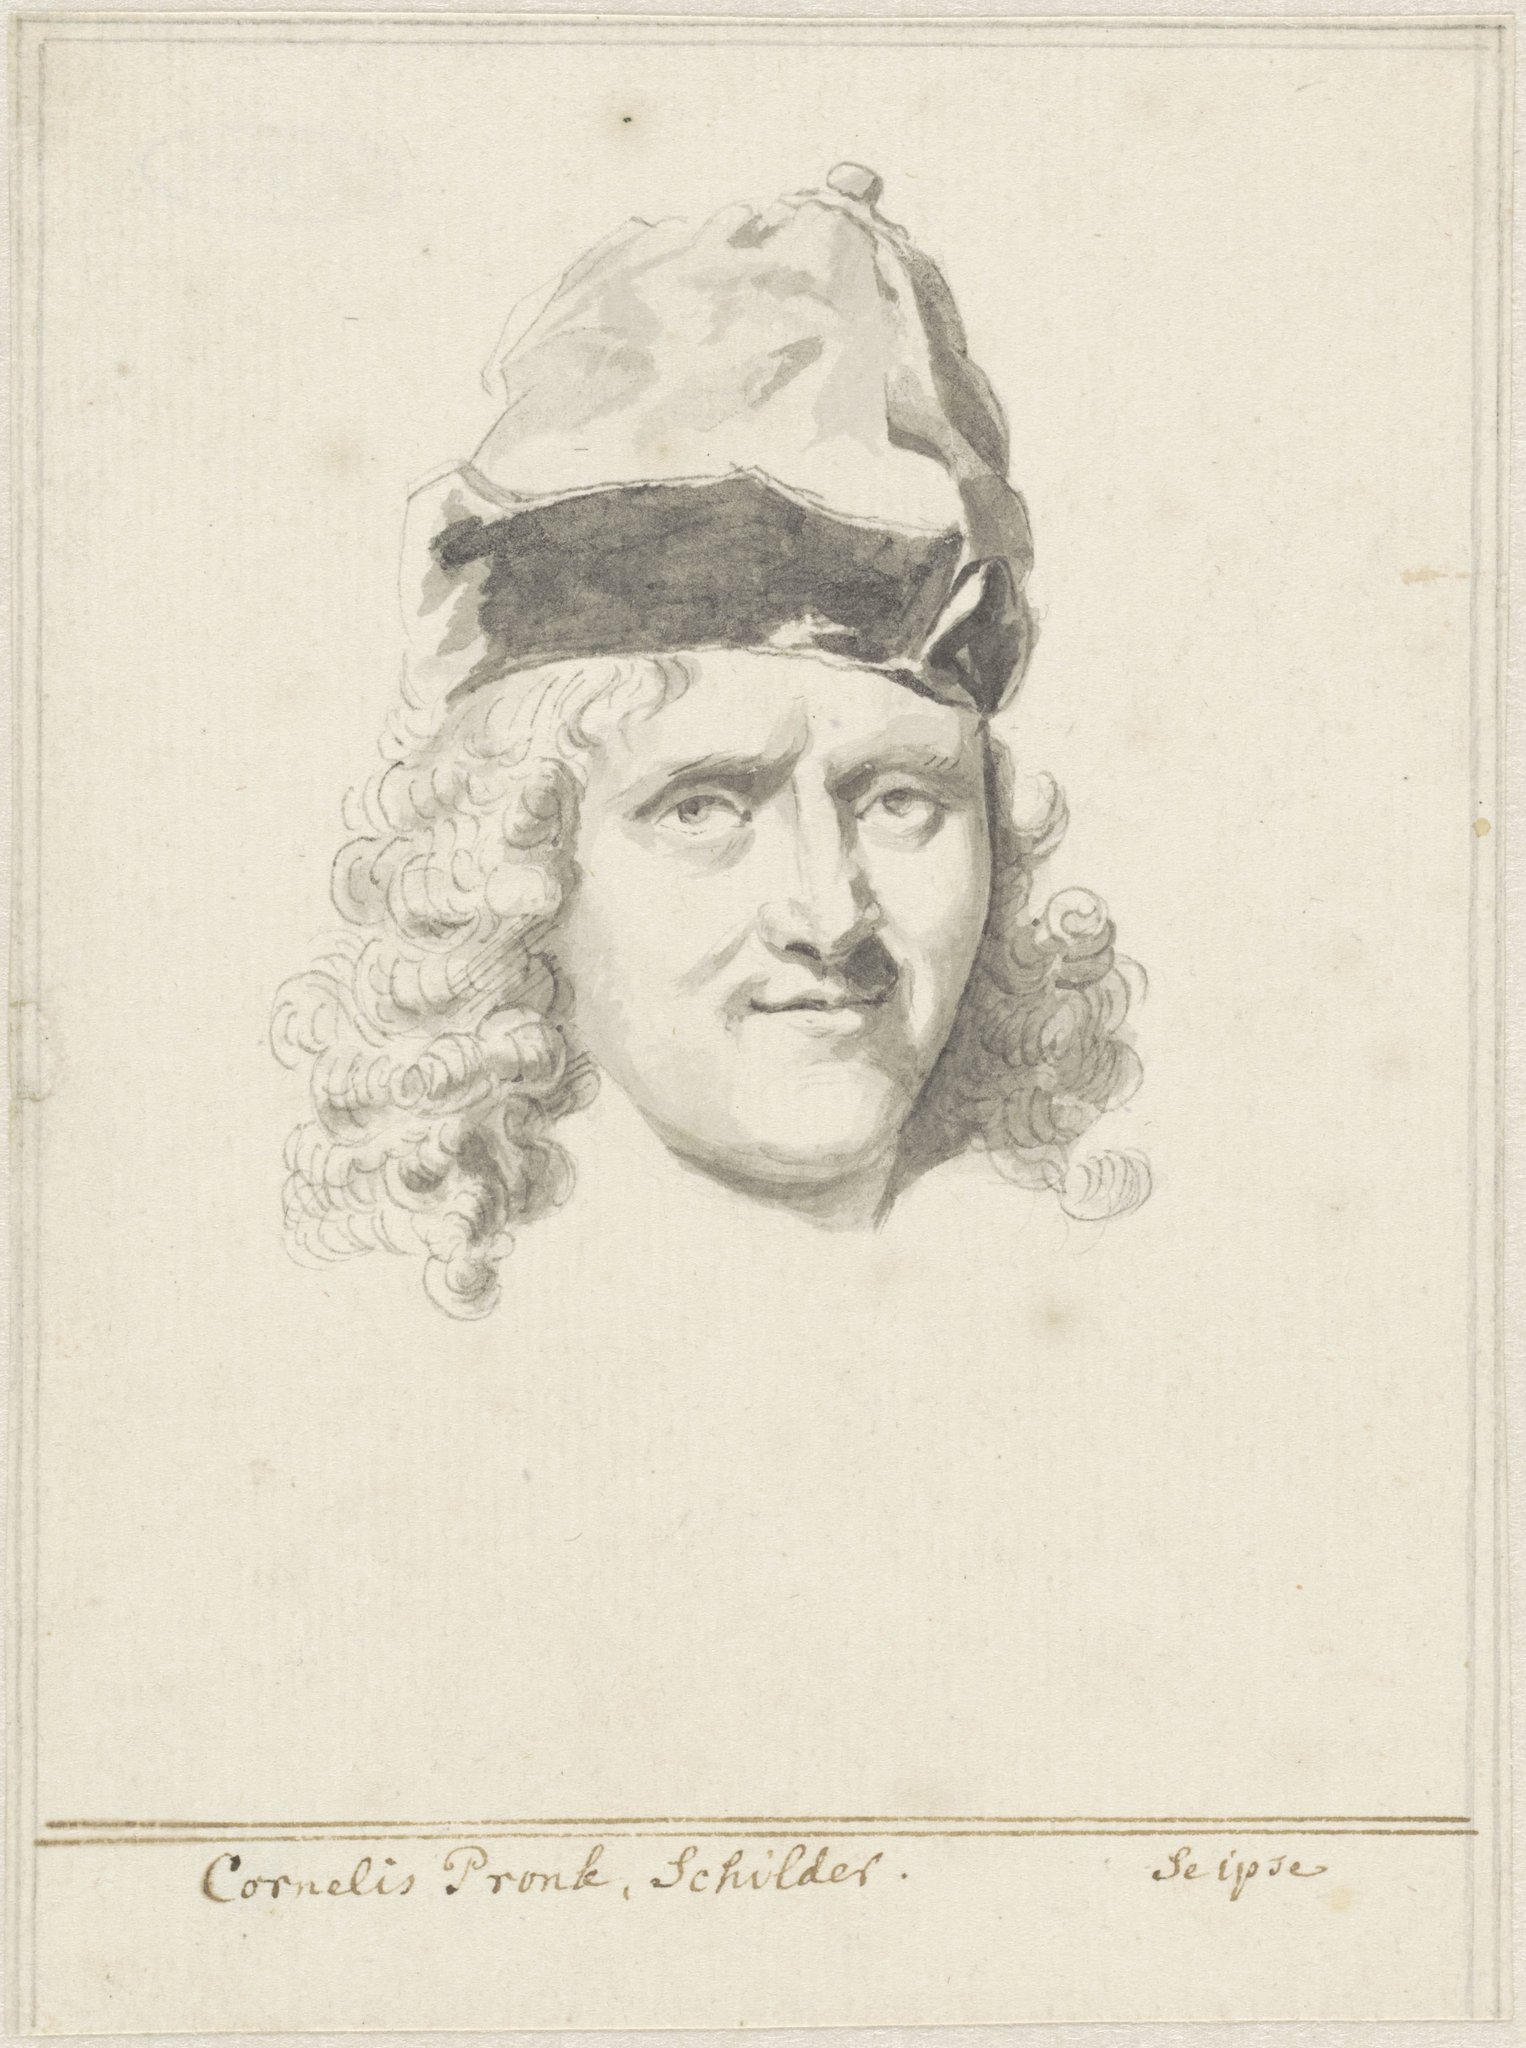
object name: drawing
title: Zelfportret met puntmuts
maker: cornelis pronk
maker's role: draughtsman, painter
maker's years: 1691-1759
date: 1701-1759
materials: ink, paper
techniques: pen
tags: amsterdam, painter, draughtsman, cornelis pronk, historical persons, portrait, self-portrait of artist